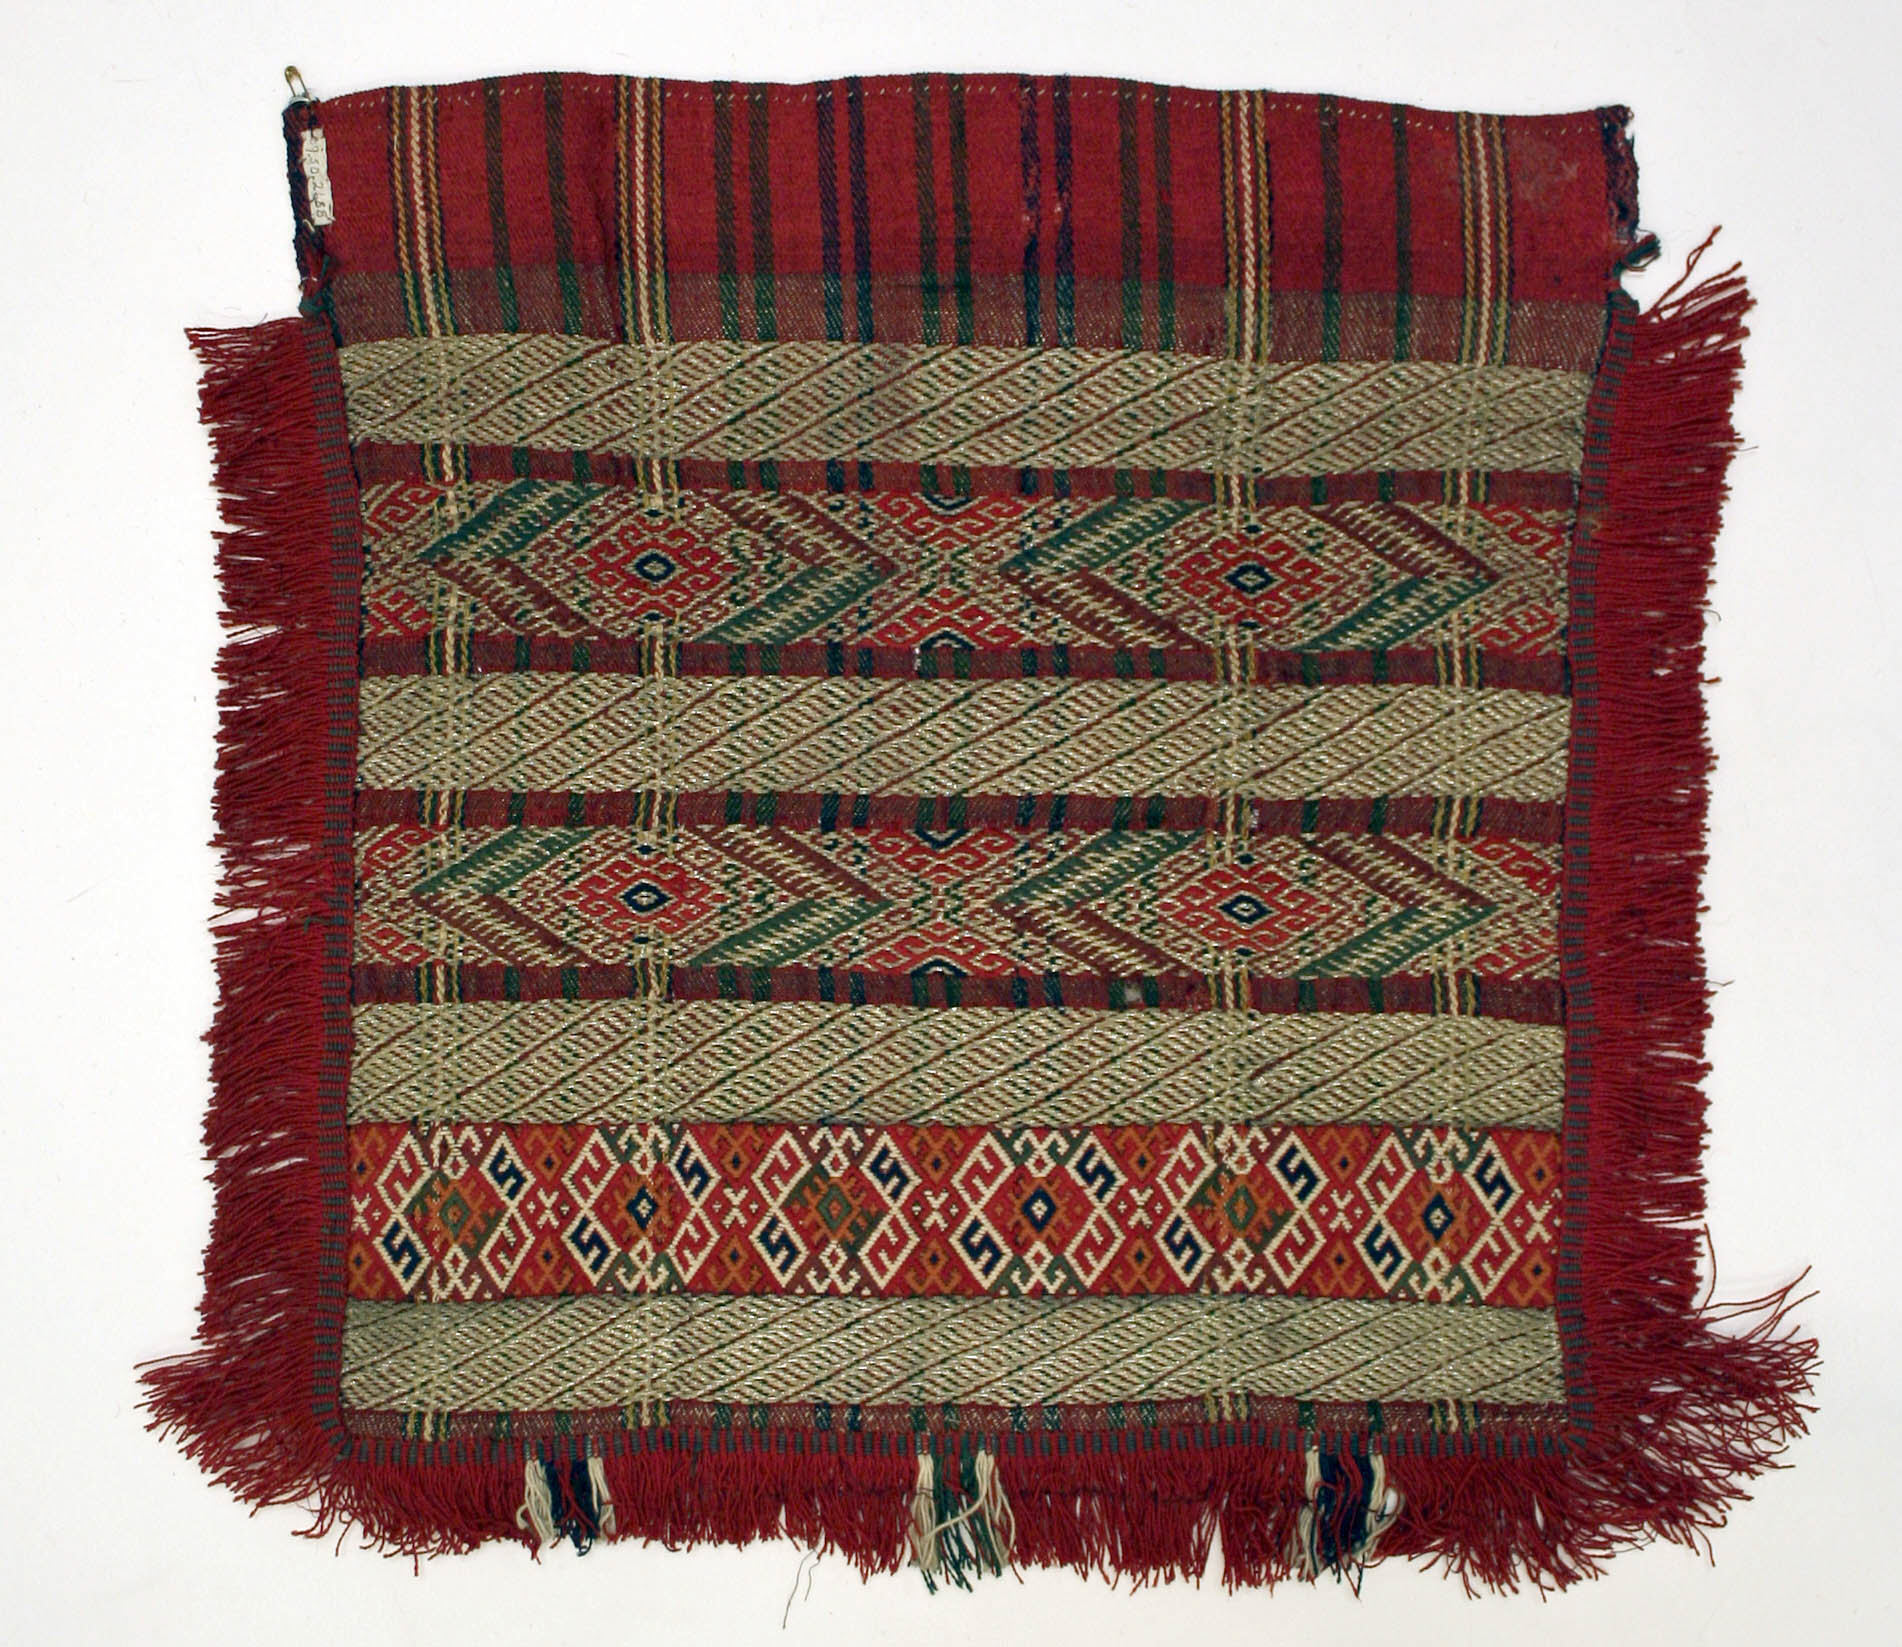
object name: apron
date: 1801-1900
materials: linen, wool